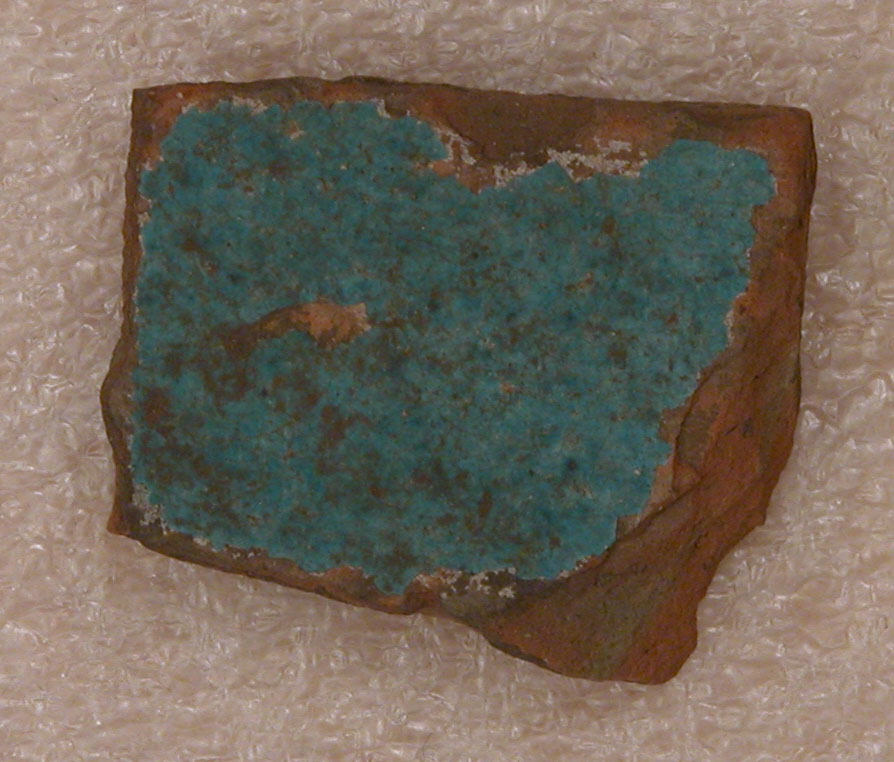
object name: tile fragment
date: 1334-1434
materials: glaze, stonepaste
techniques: painting, polychrome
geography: uzbekistan